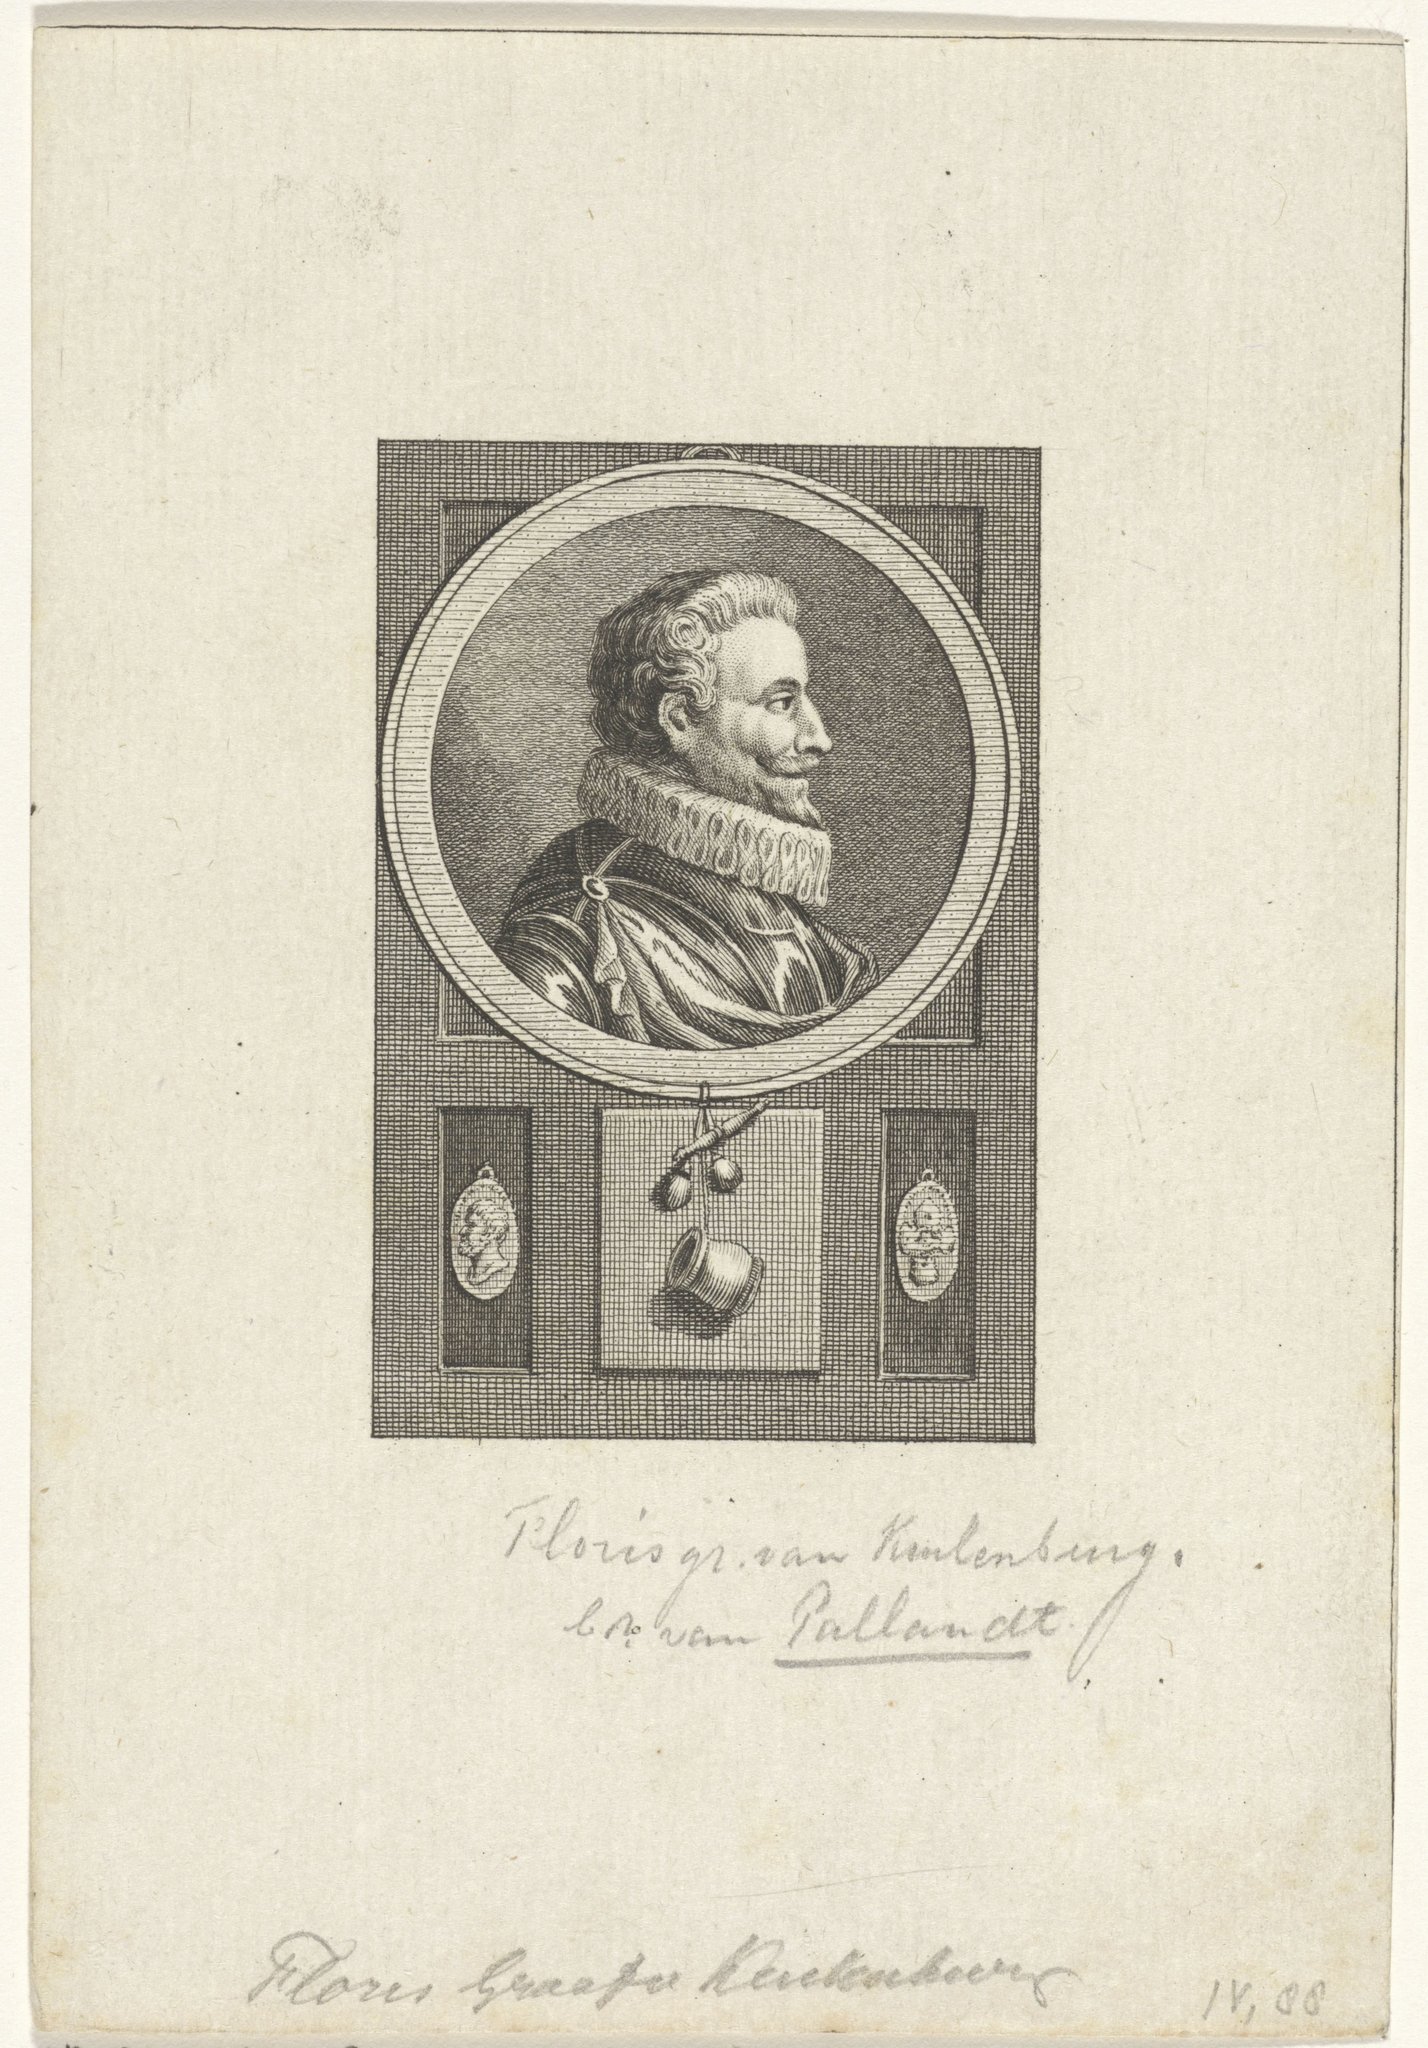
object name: print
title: Portret van Floris II van Pallandt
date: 1783-1795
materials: paper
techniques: engraving, etching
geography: amsterdam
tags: pendant, trinket, 'breloque', container of ceramics: jar, jug, pot, vase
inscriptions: collector's mark: Lugt 2228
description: Latere staat prent gebruikt in: Fokke, Jan. Geschiedenissen der Vereenigde Nederlanden voor de vaderlandsche jeugd Ie-XXVste deel. Amsterdam: Johannes Allart, 1783-1795. Deel IV.